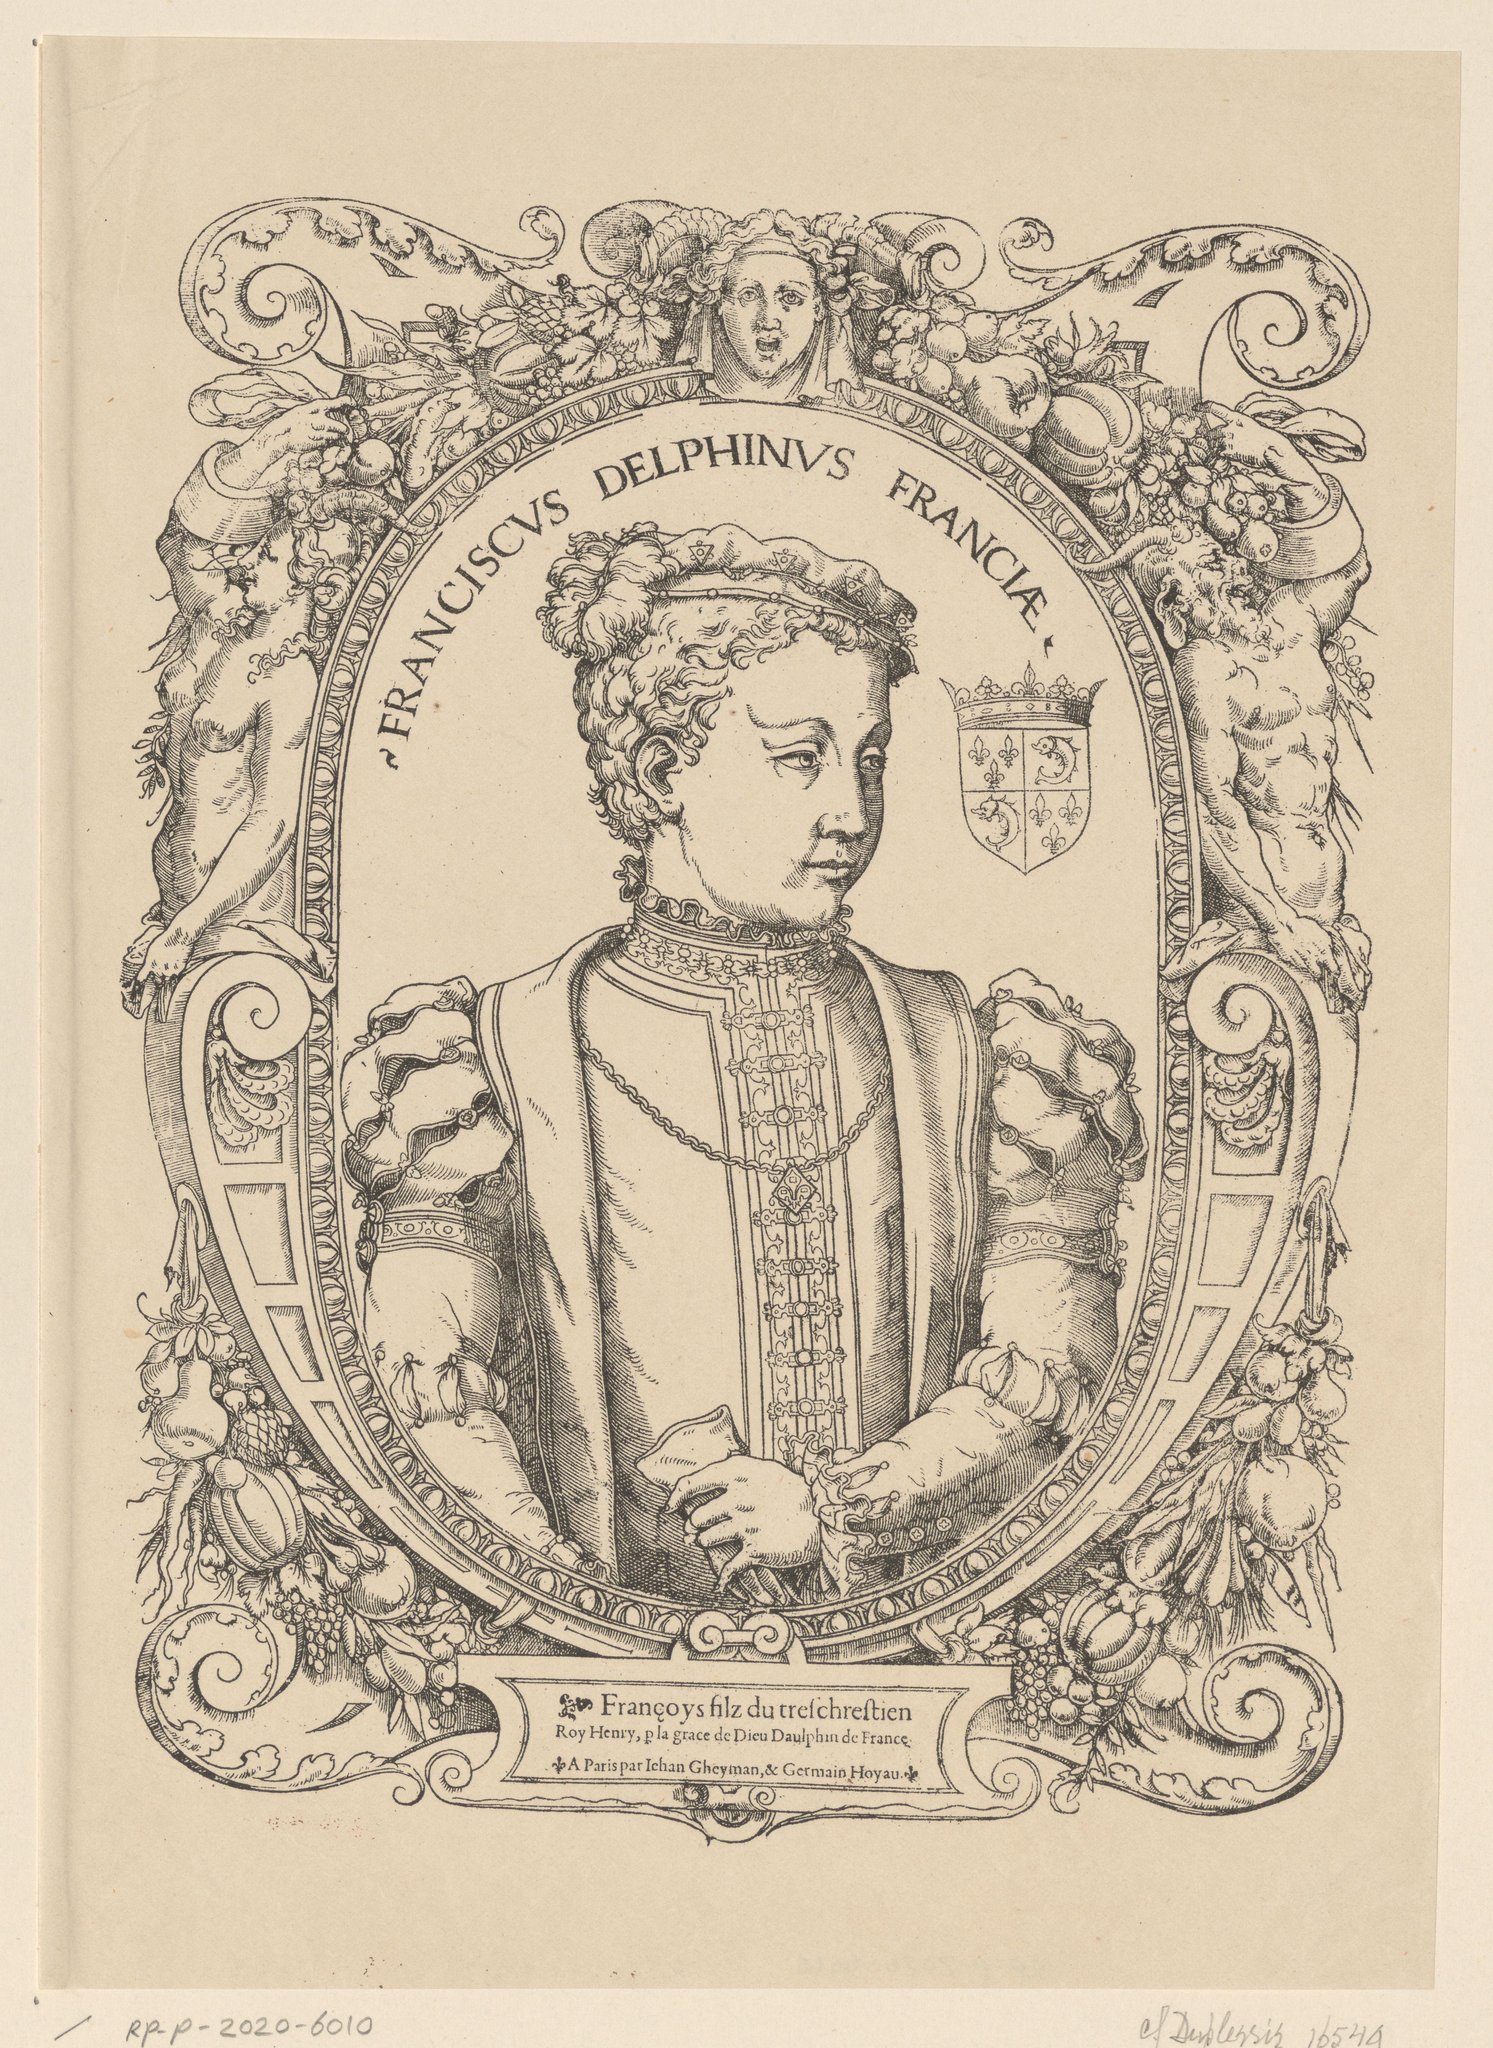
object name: photomechanical print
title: Portret van Frans II van Frankrijk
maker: Anonymous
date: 1850-1950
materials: paper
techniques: photomechanical printing process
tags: paris, fruits and vegetables ~ ornament, historical persons, king, armorial bearing, heraldry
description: Reproductie van een originele houtsnede, uitgegeven door Johan Gheyman en Germain Hoyau.